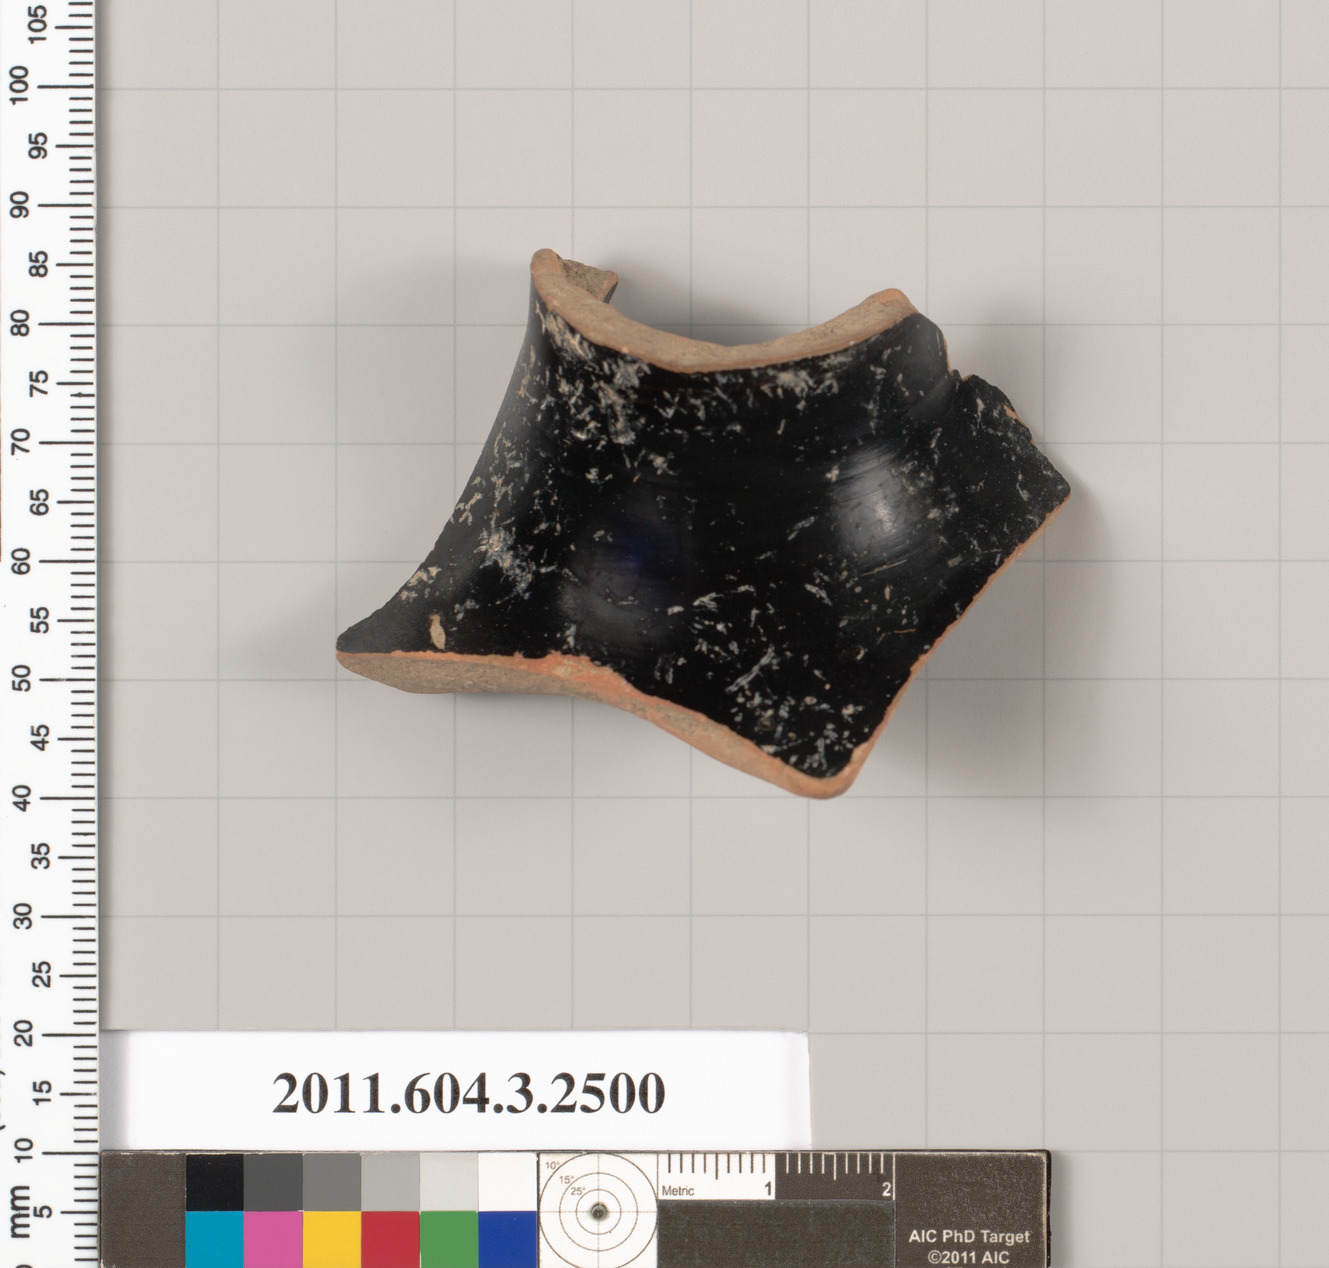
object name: kylix fragment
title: Terracotta fragment of a kylix (drinking cup)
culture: greek, attic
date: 600-401 BCE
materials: terracotta